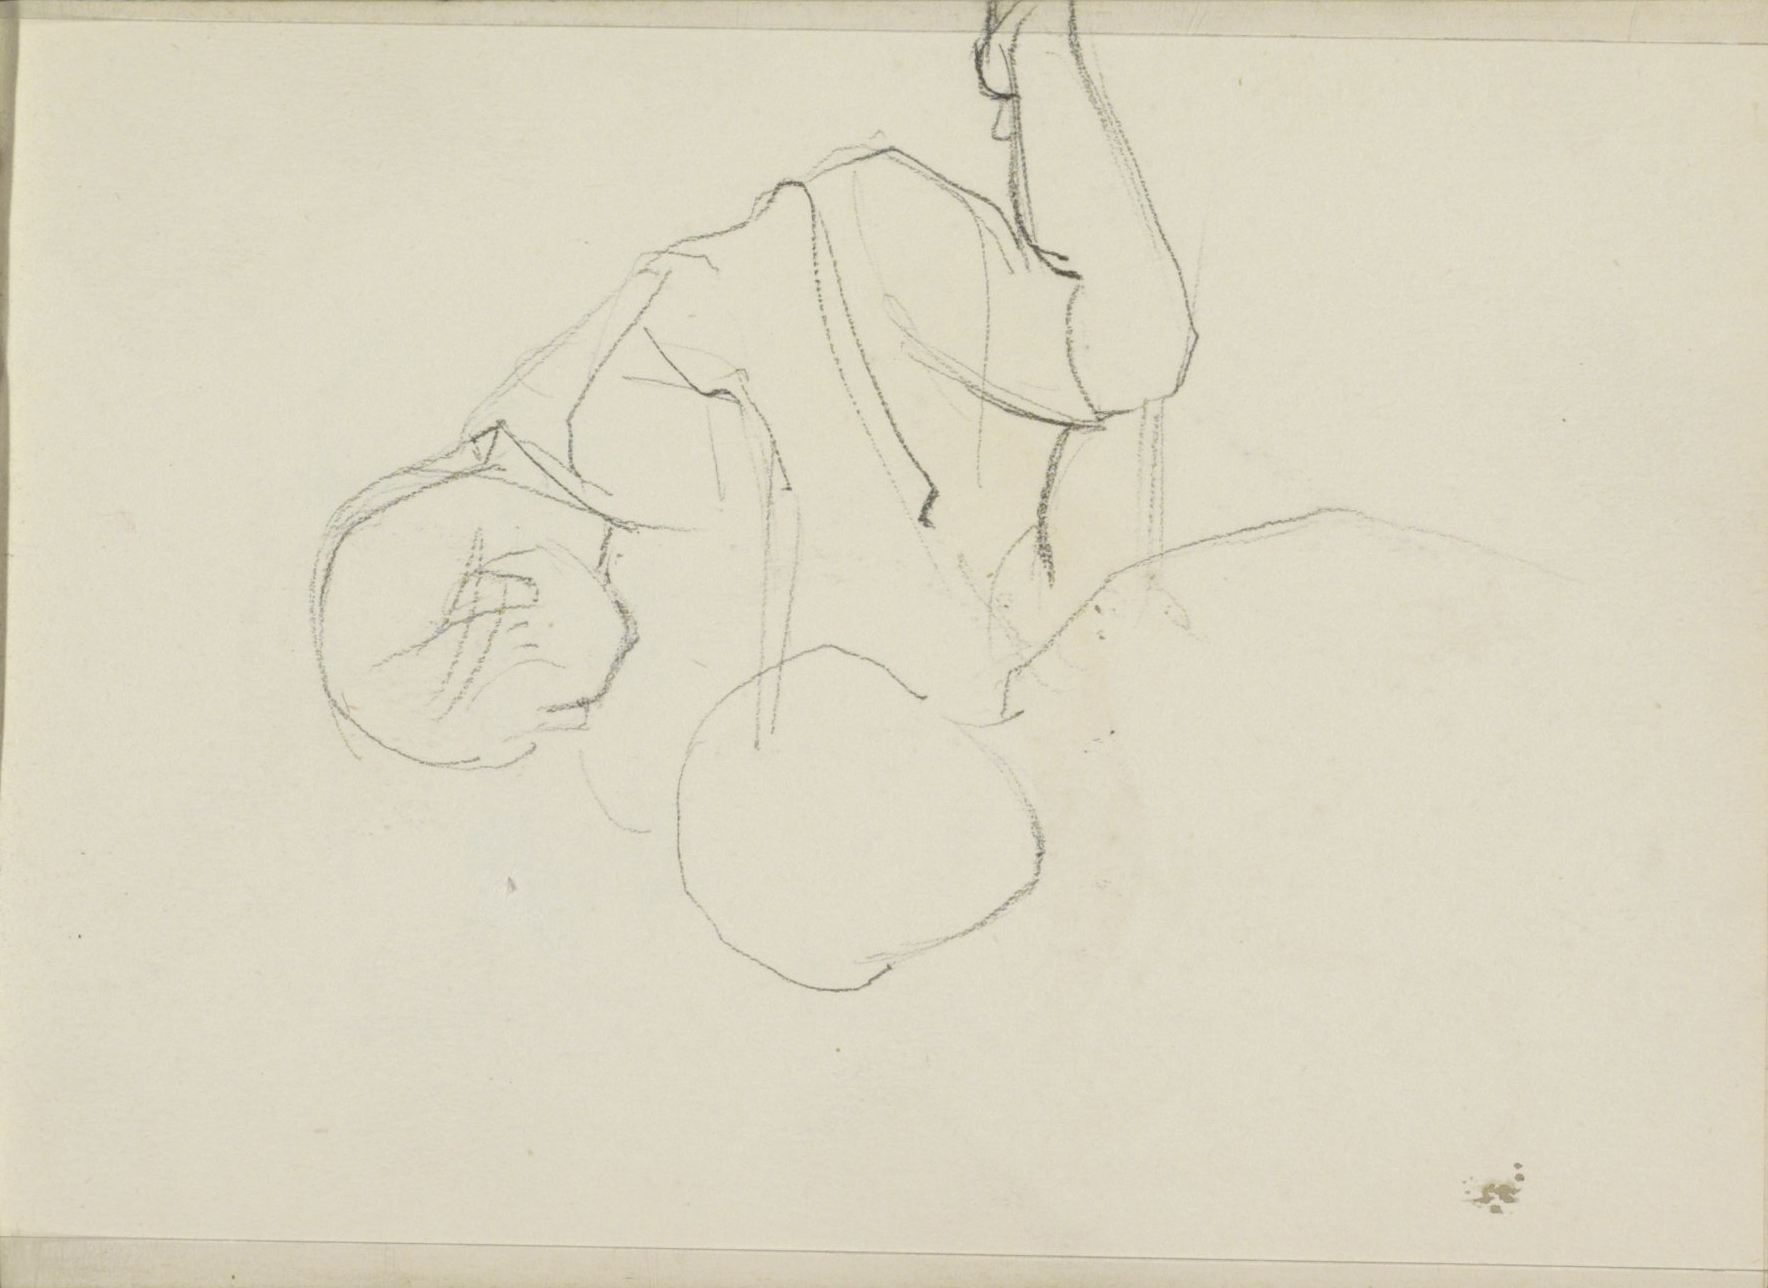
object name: sketchbook leaf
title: Kind dat voorovergebogen op de knieën zit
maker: a.a.l. de grammont-hubrecht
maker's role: draughtsman, painter, print maker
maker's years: 1855-1913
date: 1865-1913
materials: chalk, paper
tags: child, kneeling on both knees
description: Blad 23 recto uit een schetsboek met 38 bladen.